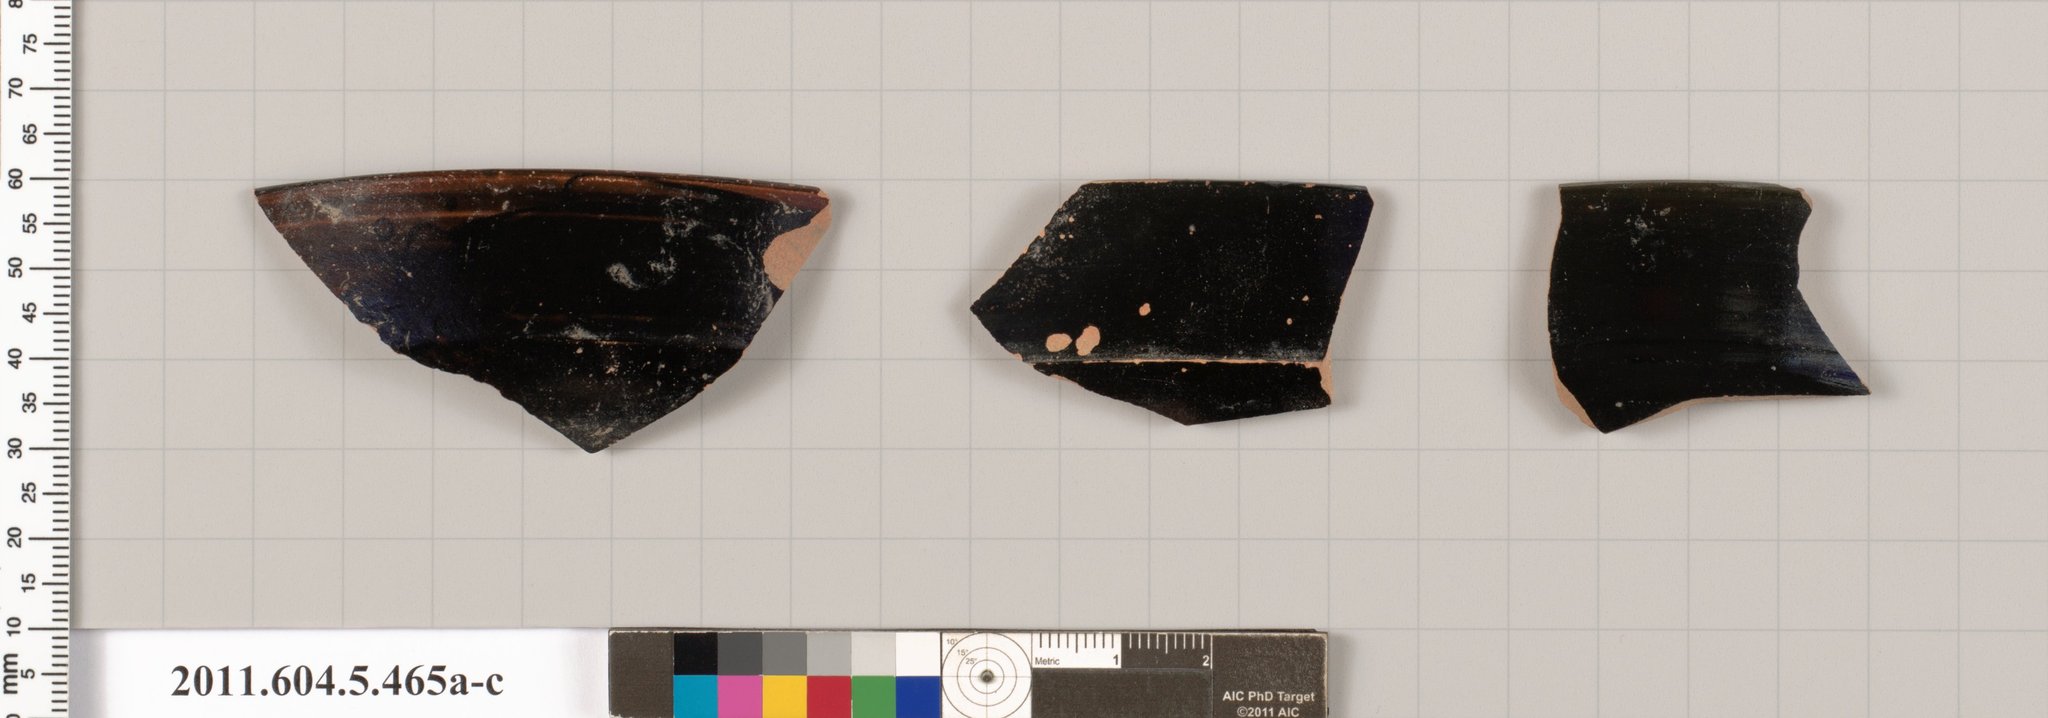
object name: kylix fragment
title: Terracotta rim fragments of kylikes (drinking cups)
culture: greek, attic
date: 600-401 BCE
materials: terracotta